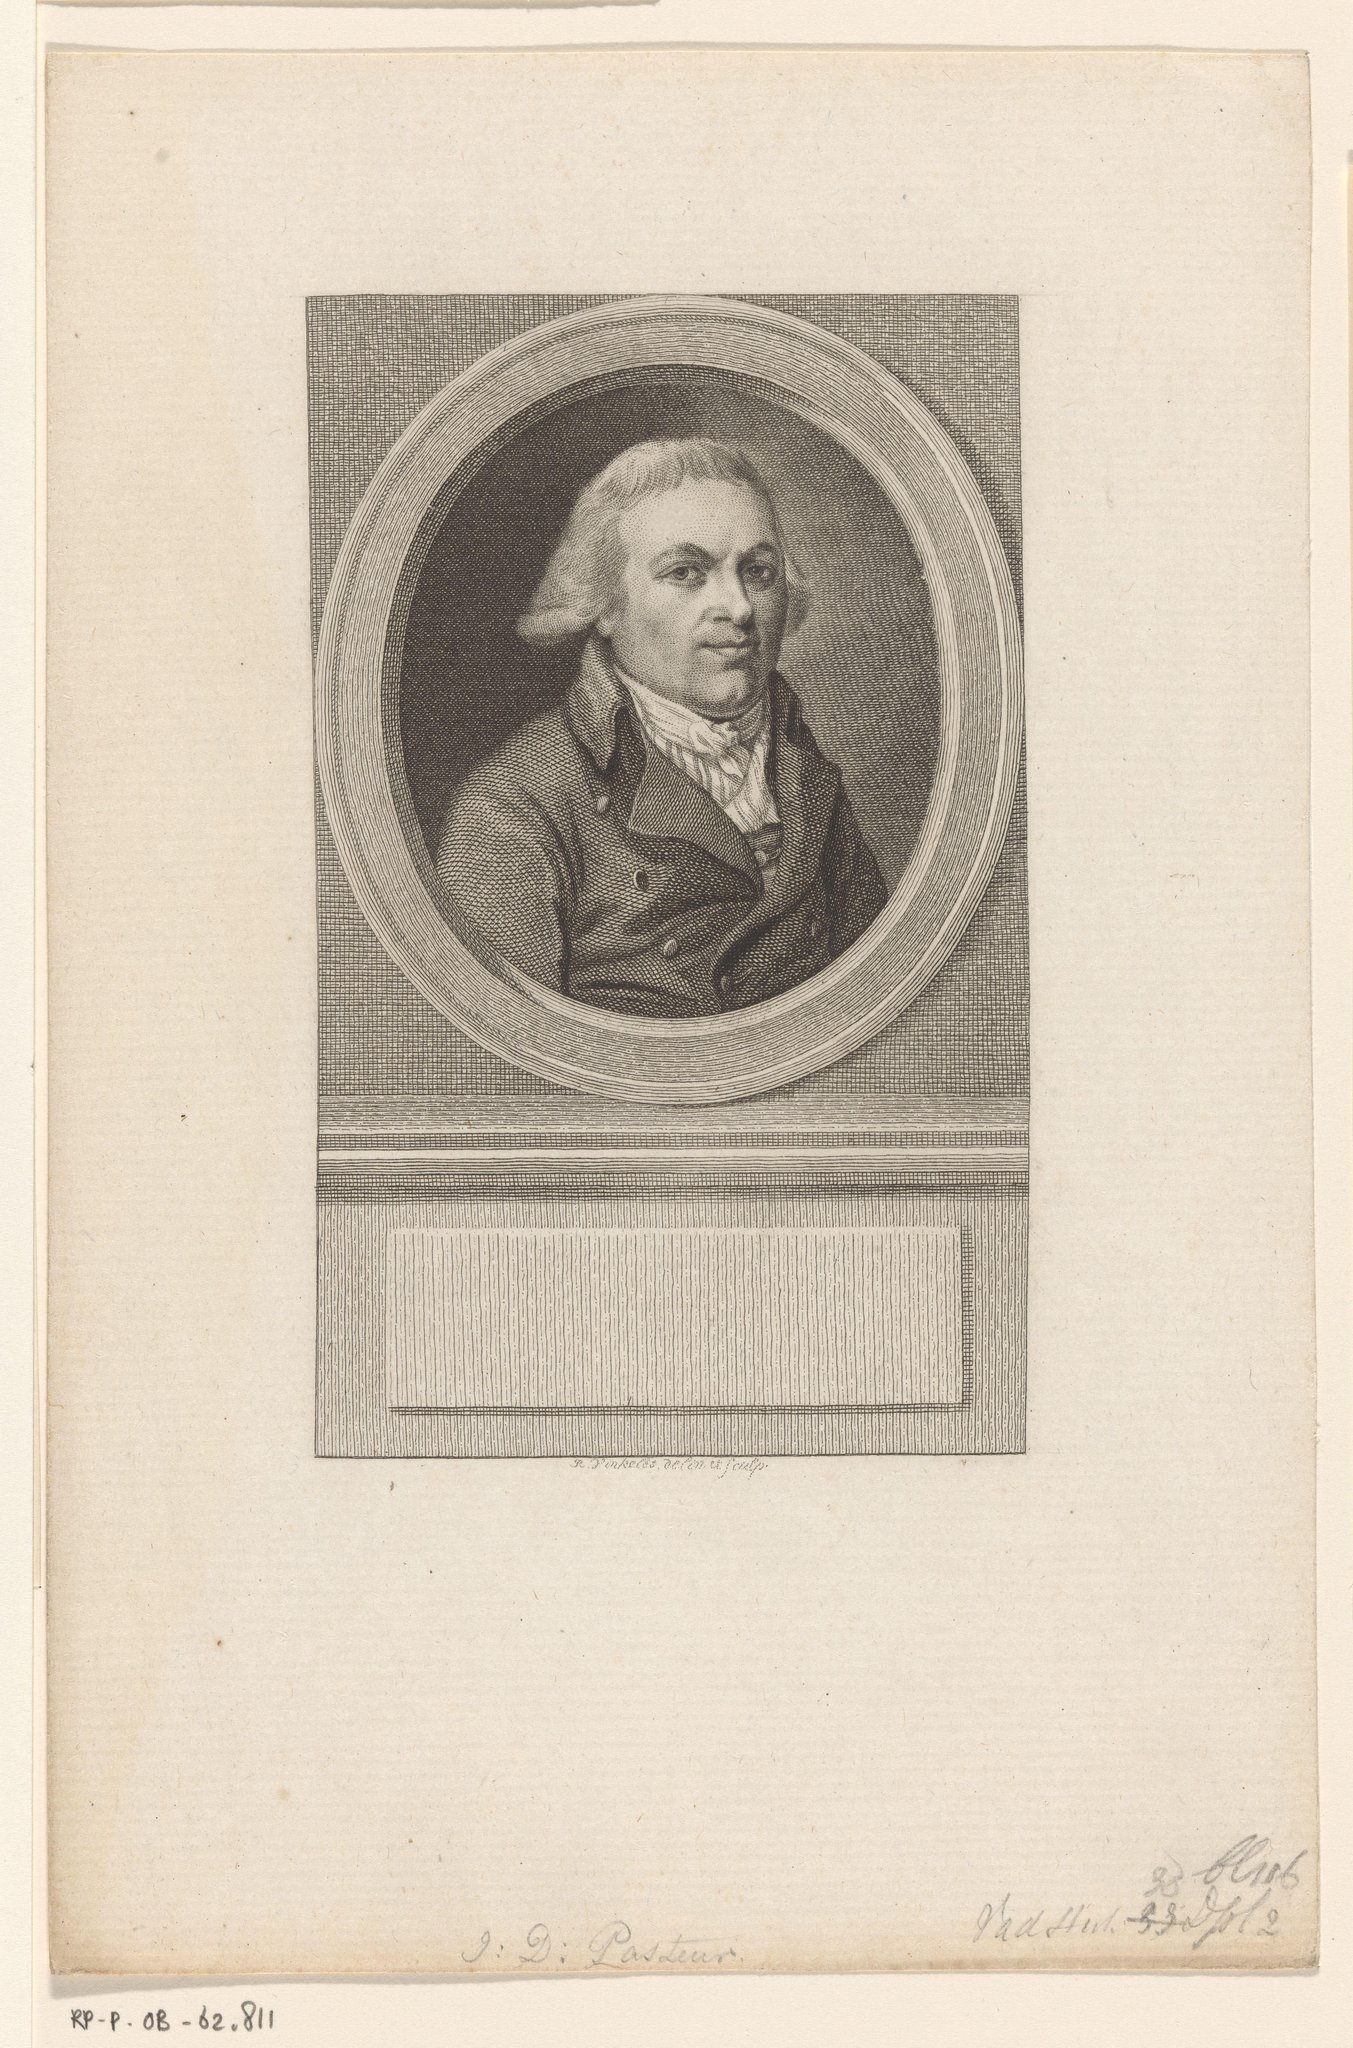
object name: print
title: Portret van Jan David Pasteur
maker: reinier vinkeles (i)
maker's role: draughtsman, print maker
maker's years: 1741-1816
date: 1786-1809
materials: paper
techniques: engraving, etching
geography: amsterdam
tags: leiden, jan david pasteur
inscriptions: collector's mark: Lugt 2228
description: Latere staat prent ook gebruikt als boekillustratie in: Wagenaar, Jan. Vaderlandsche historie, (...) ten vervolge van Wagenaars Vaderlandsche historie. Dl. 1-43. Amsterdam: Johannes Allart, 1786-1809.